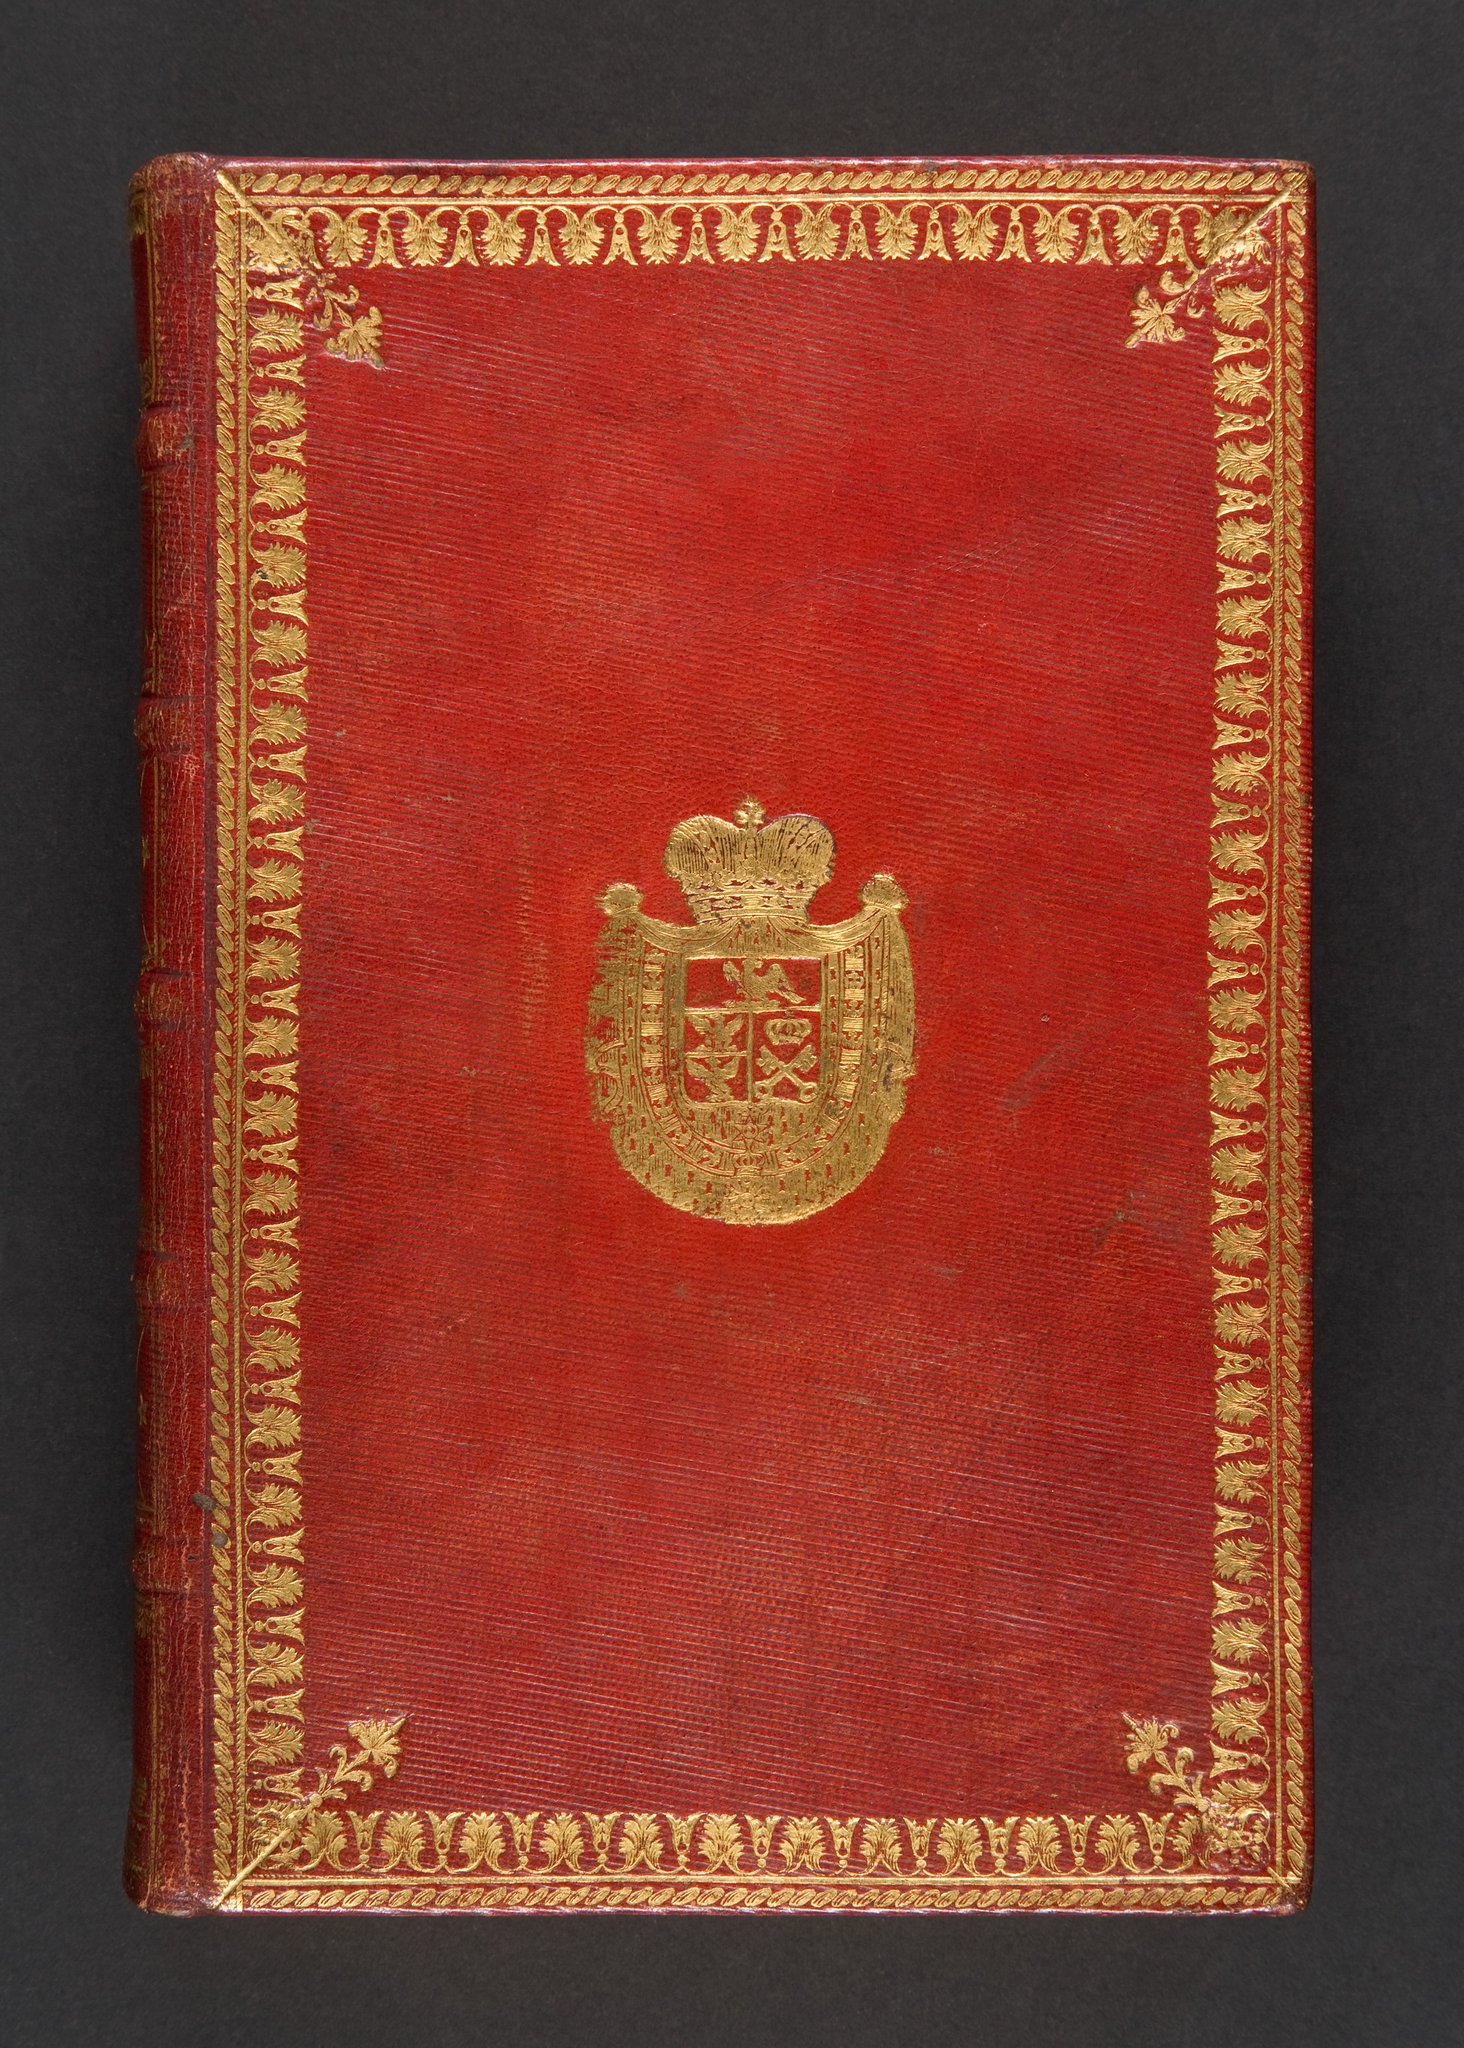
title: Uffizio della Settimana Santa : colle rubriche volgari, argomenti de' Salmi, spiegazione delle cerimonie e misterj, con osservazioni, e riflessioni divote dell'abate Alessandro Mazzinelli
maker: alessandro mazzinelli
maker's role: author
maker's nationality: italian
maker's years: 1650-1750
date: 1794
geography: italy